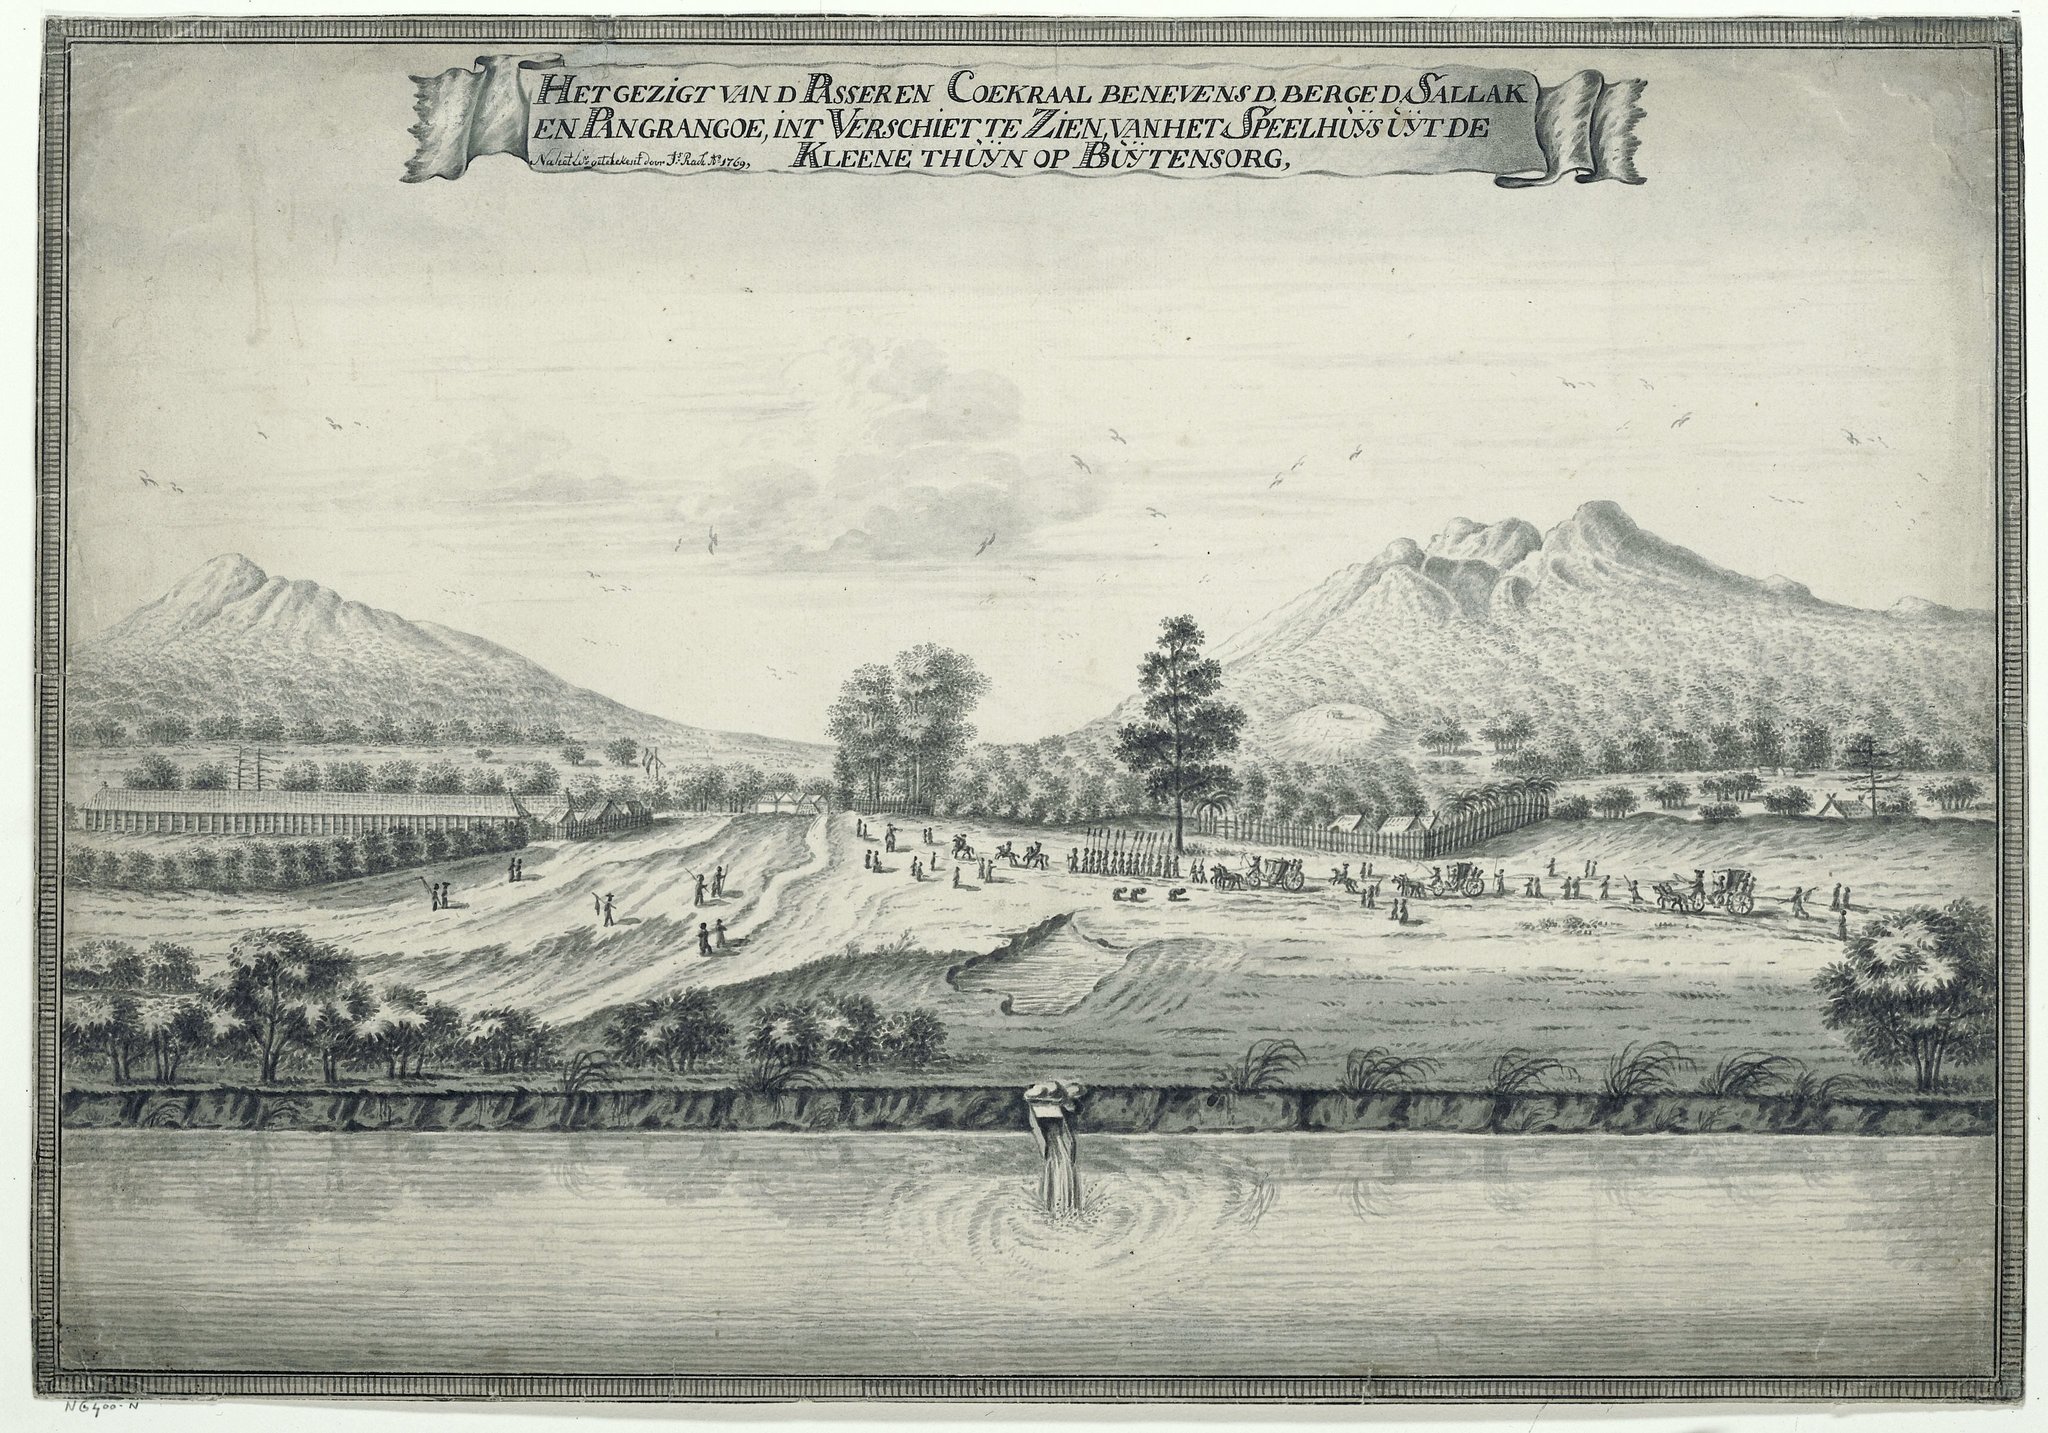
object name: drawing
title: Het Gezigt van d Passer en Coekraal benevens d. berge d. Sallak en Pangrangoe, int Verschiet te Zien, van het Speelhuijs uijt de Kleene Thuijn op Buijtensorg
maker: johannes rach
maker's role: draughtsman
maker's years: 1720-1783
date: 1769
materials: ink, paper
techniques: brush, pen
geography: buitenzorg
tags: landscapes in tropical and sub-tropical regions, mountains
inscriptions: date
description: Rivierlandschap met op de voorgrond een rivier waarin in het midden een afwateringsbuis uitkomt. Daarachter landschap met twee bergen, verschillende figuren en een stoet met drie koetsen, voorafgegaan door een kolonne lansiers en ruiters. Links een laag gebouw waar de Nederlandse vlag uithangt; rechts omheining waarbinnen bebouwing.